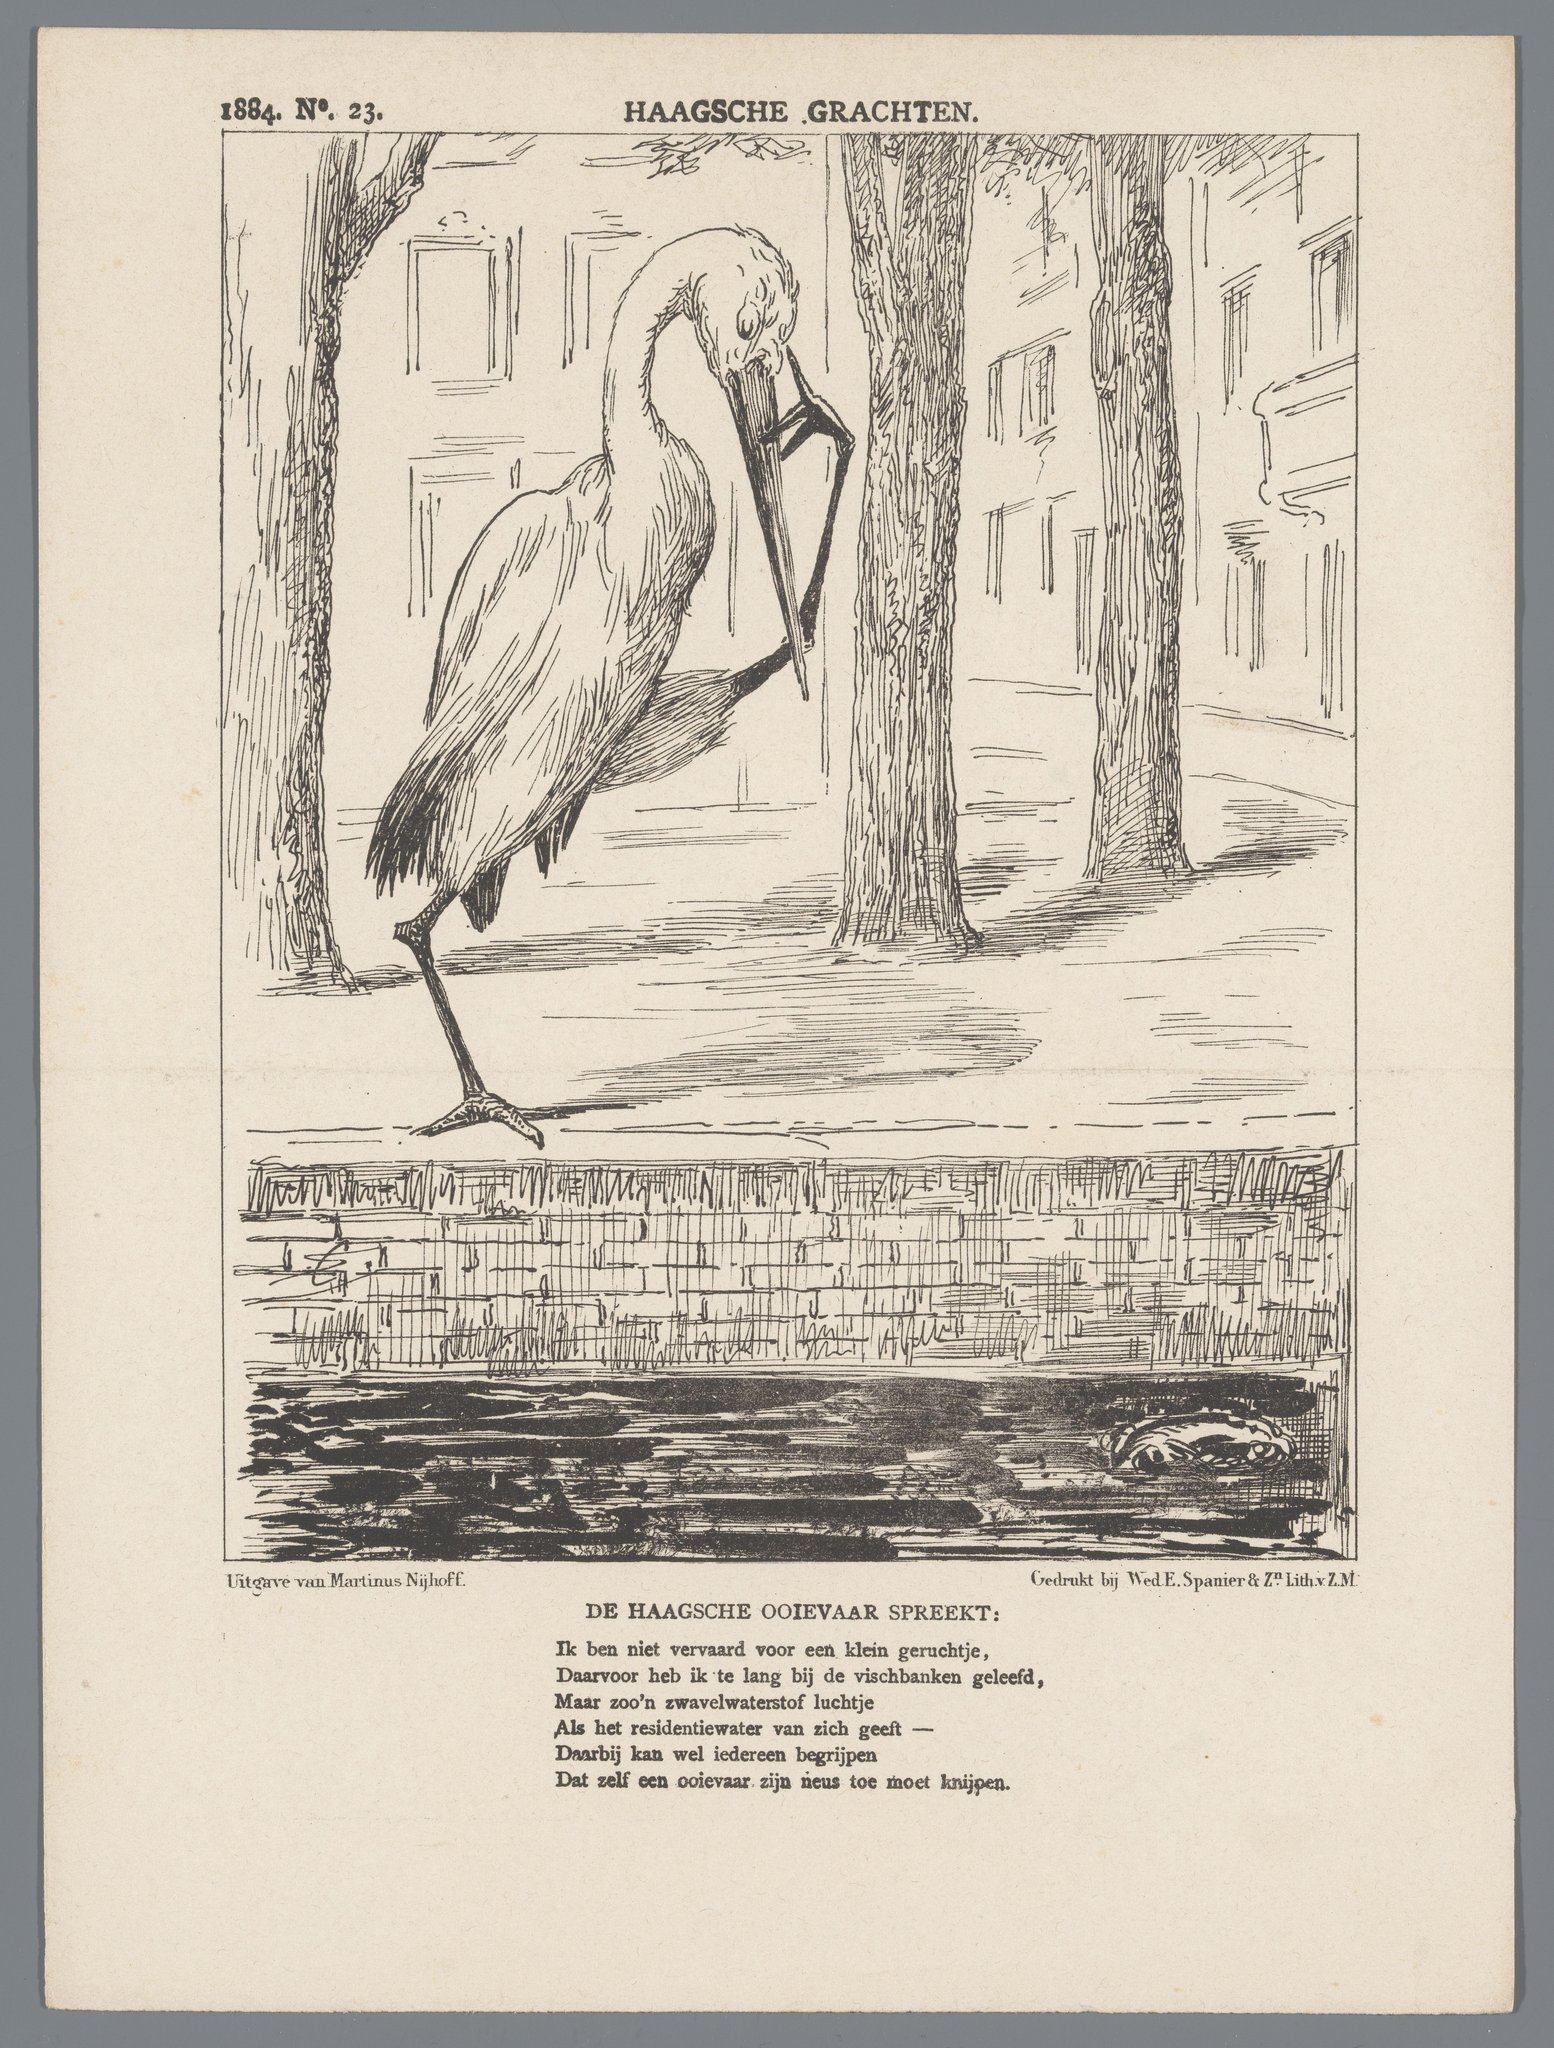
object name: cartoon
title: Spotprent over de stinkende grachten in Den Haag,1884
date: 1884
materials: paper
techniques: lithograph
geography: the hague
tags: the hague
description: Spotprent over de stinkende grachten in Den Haag. Een ooievaar houdt zijn neusgaten dicht. Plaat verschenen bij het weekblad De Nederlandsche Spectator, nr. 23, 1884.